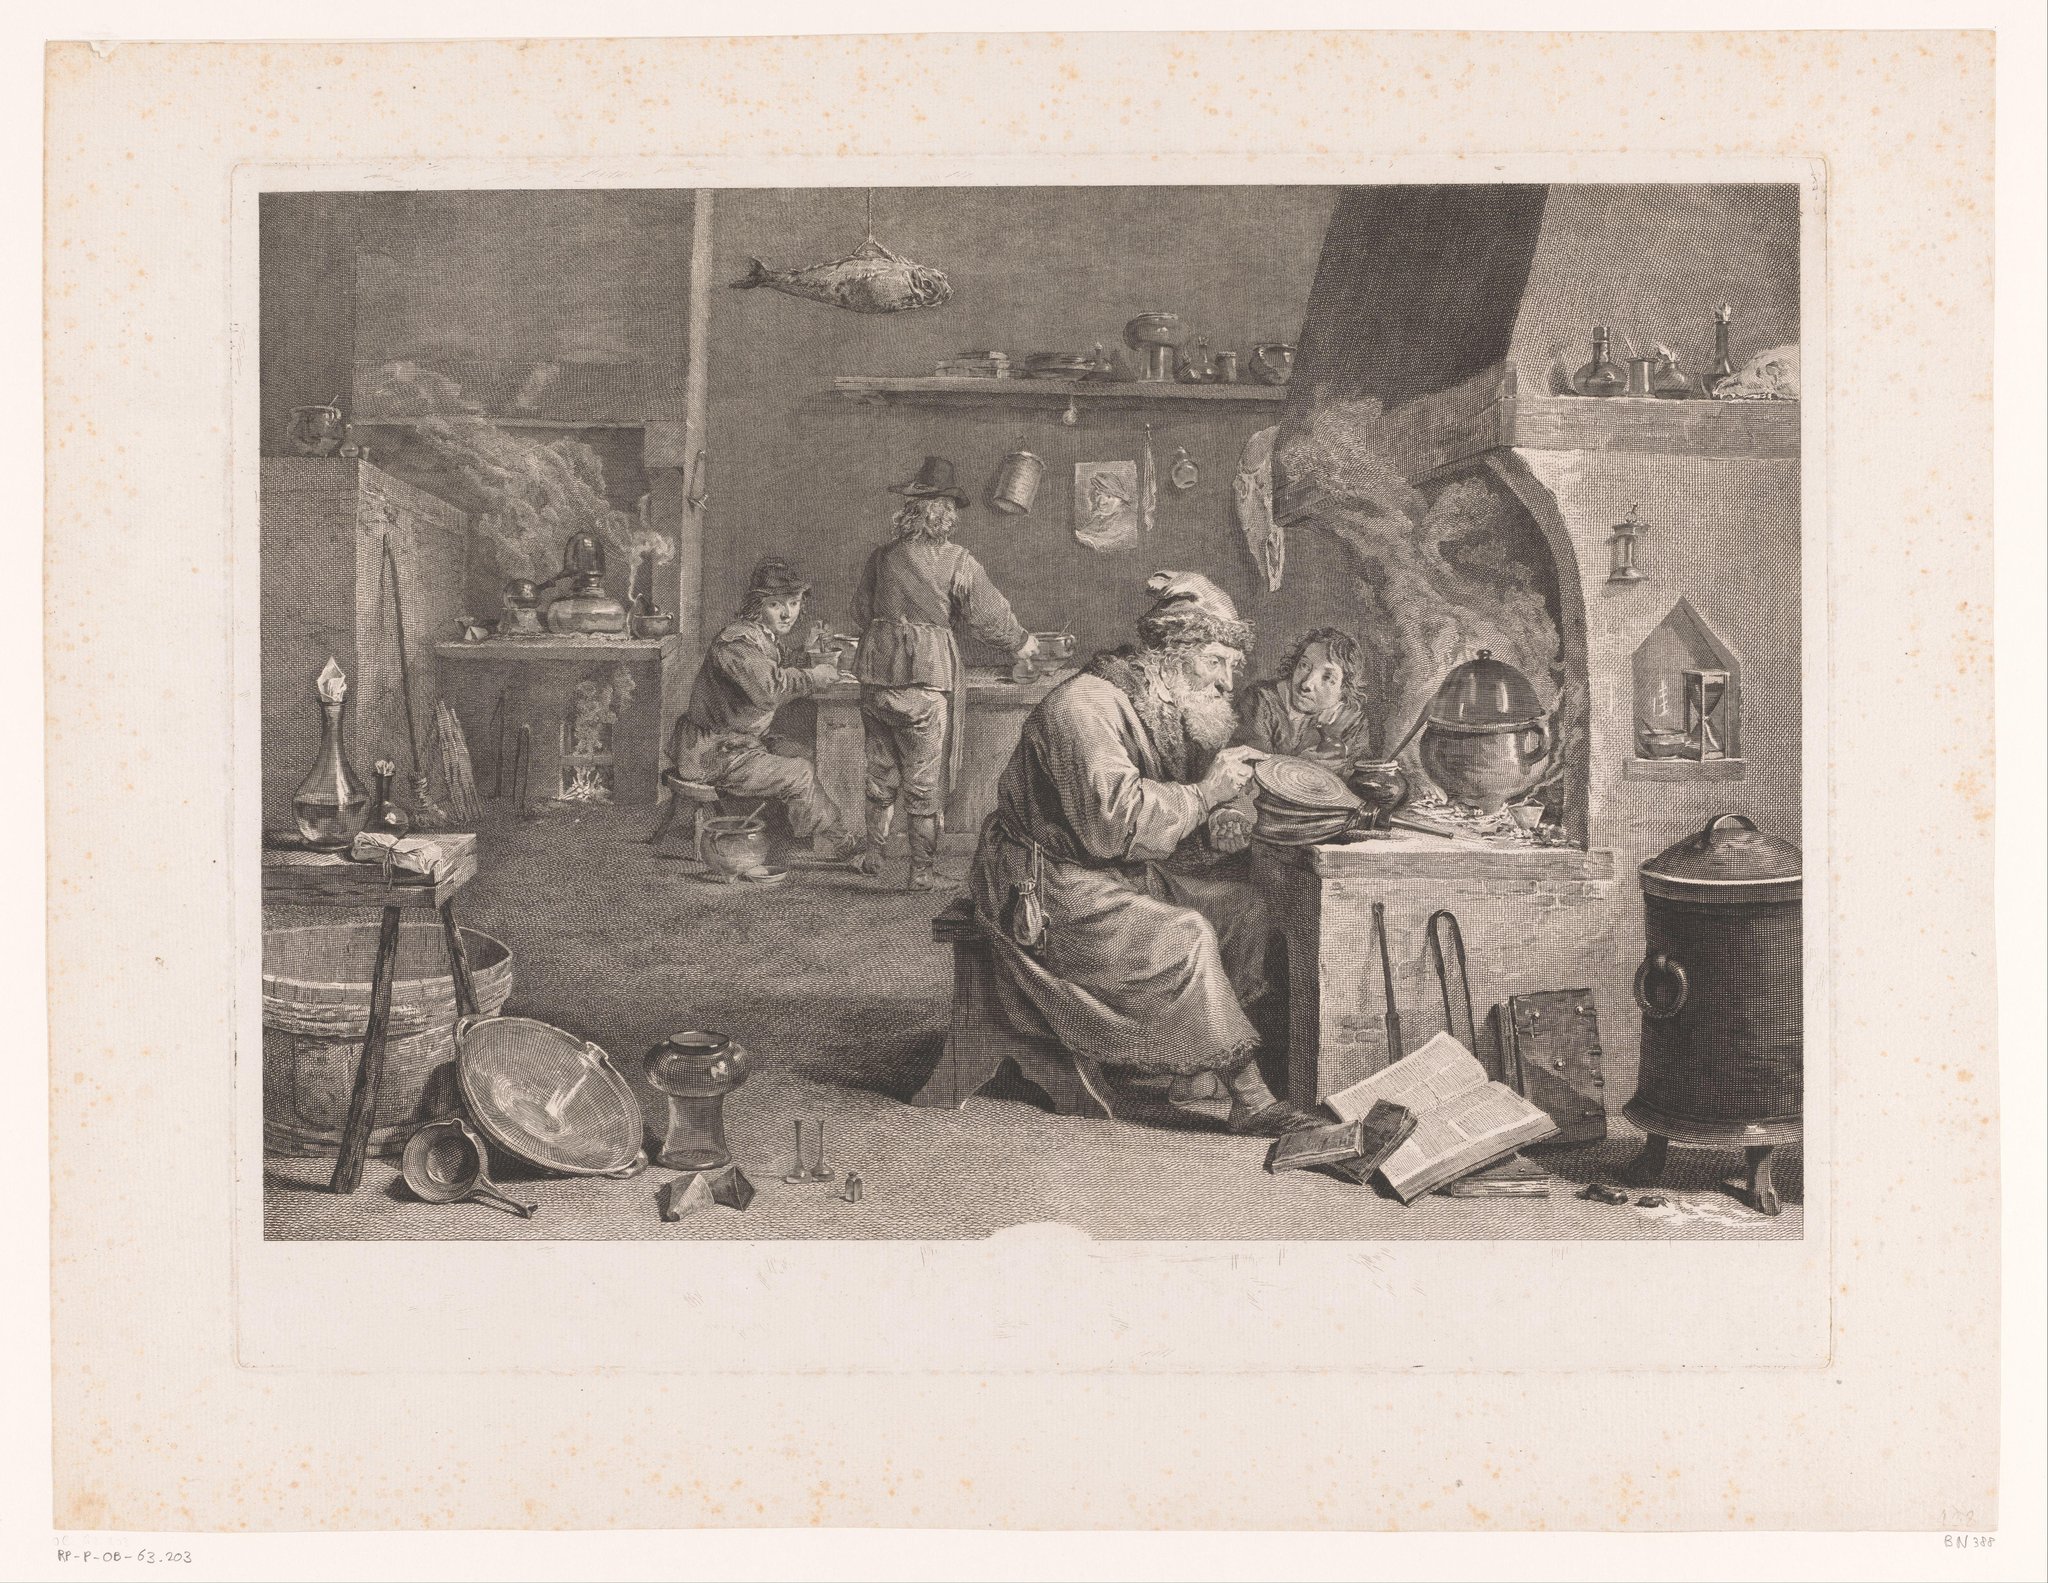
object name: print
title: Le Chimiste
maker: jacques-philippe le bas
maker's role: draughtsman, print maker, publisher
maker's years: 1707-1783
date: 1747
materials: paper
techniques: engraving, etching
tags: alchemist at work, laboratory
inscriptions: collector's mark: Lugt 240